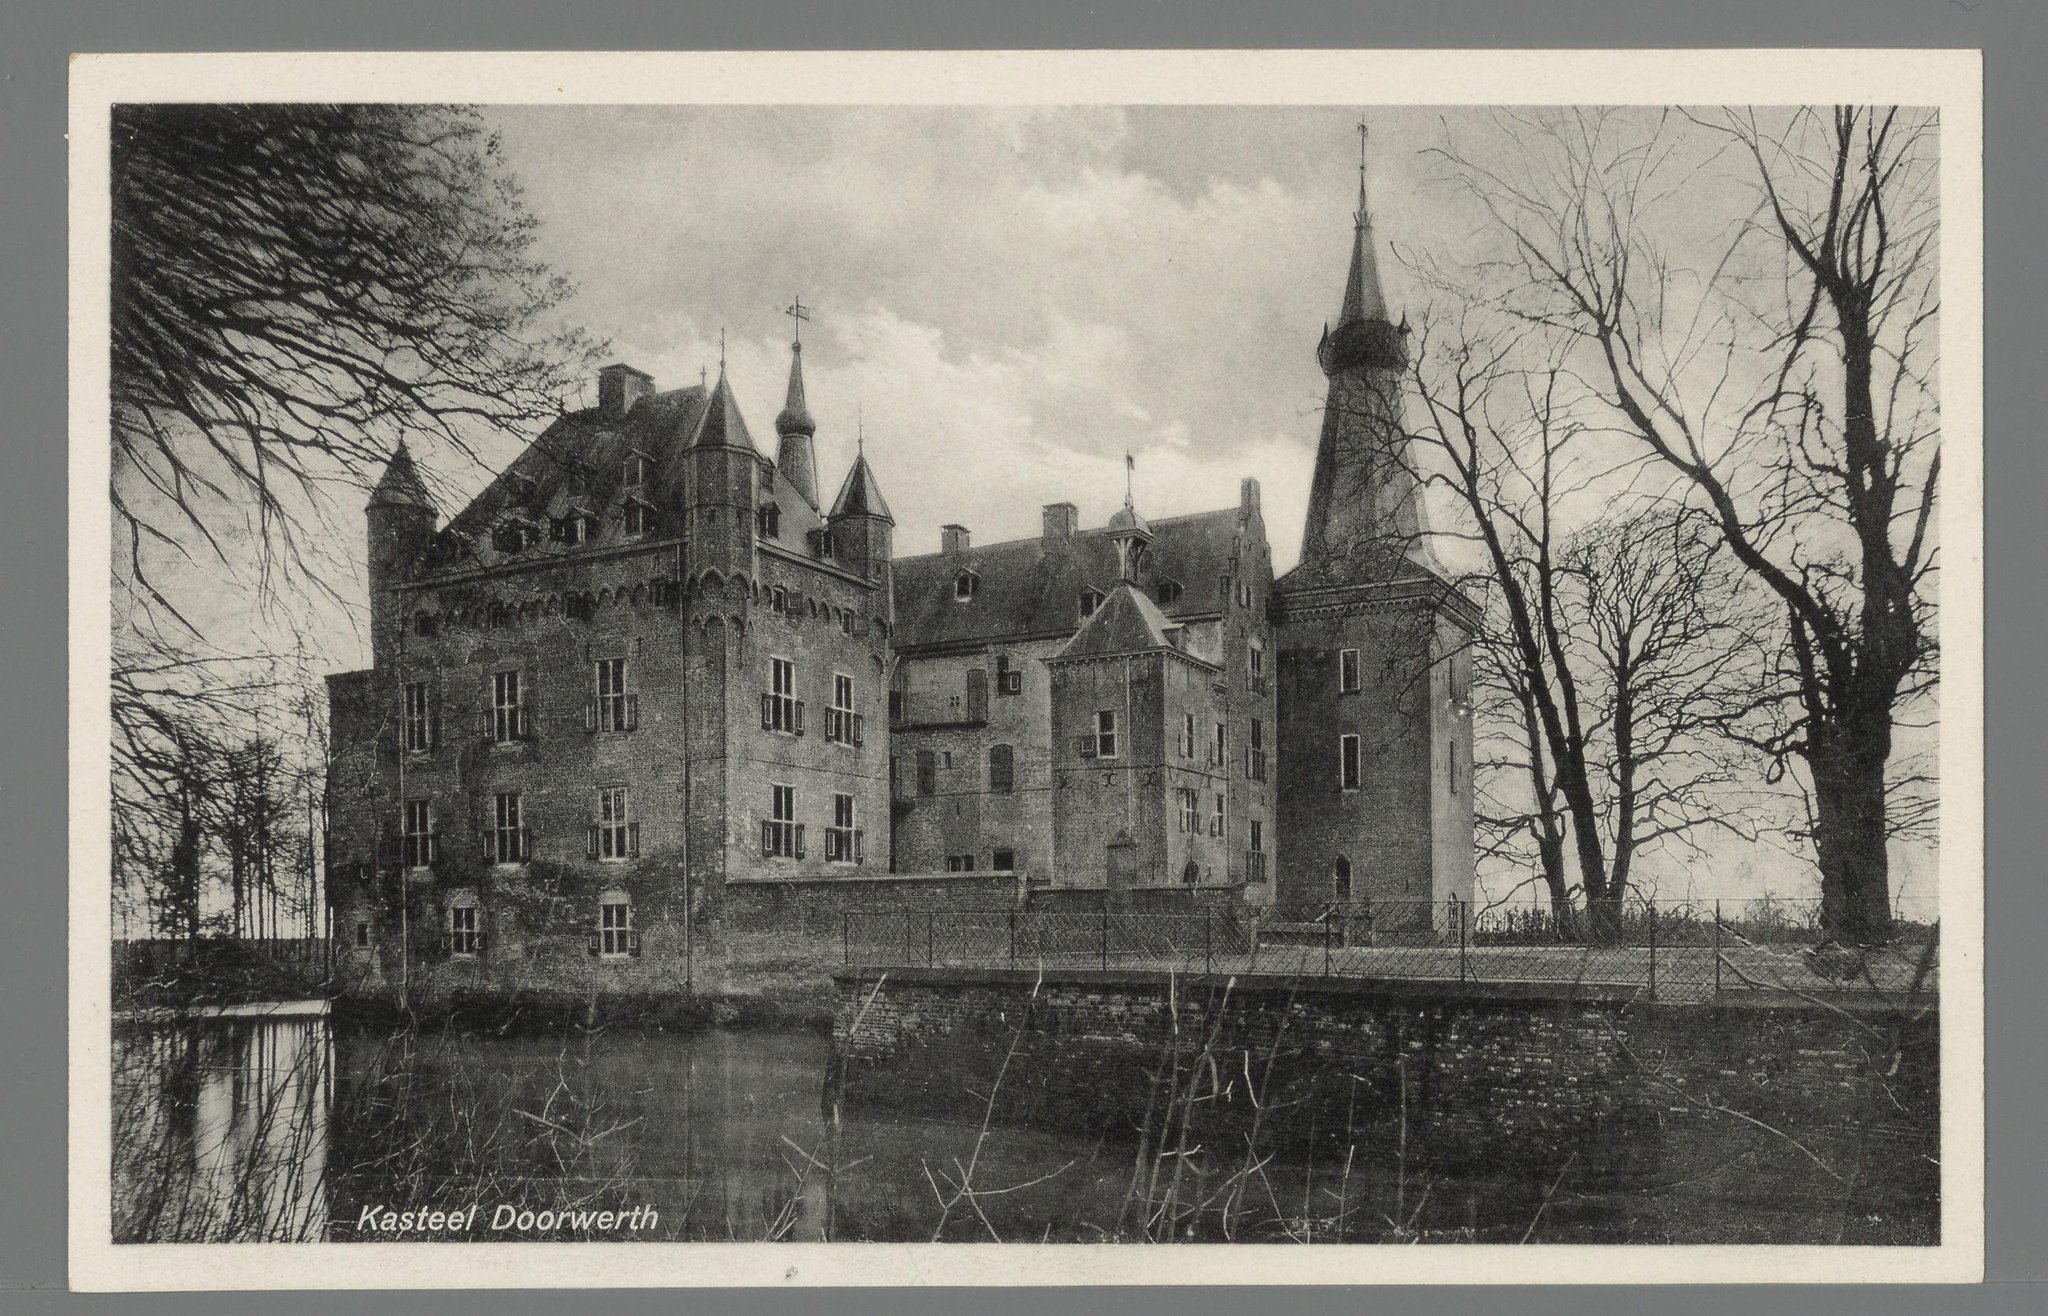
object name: photomechanical print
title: Kasteel Doorwerth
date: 1927-1935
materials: cardboard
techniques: autotype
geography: doorwerth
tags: castle, canal